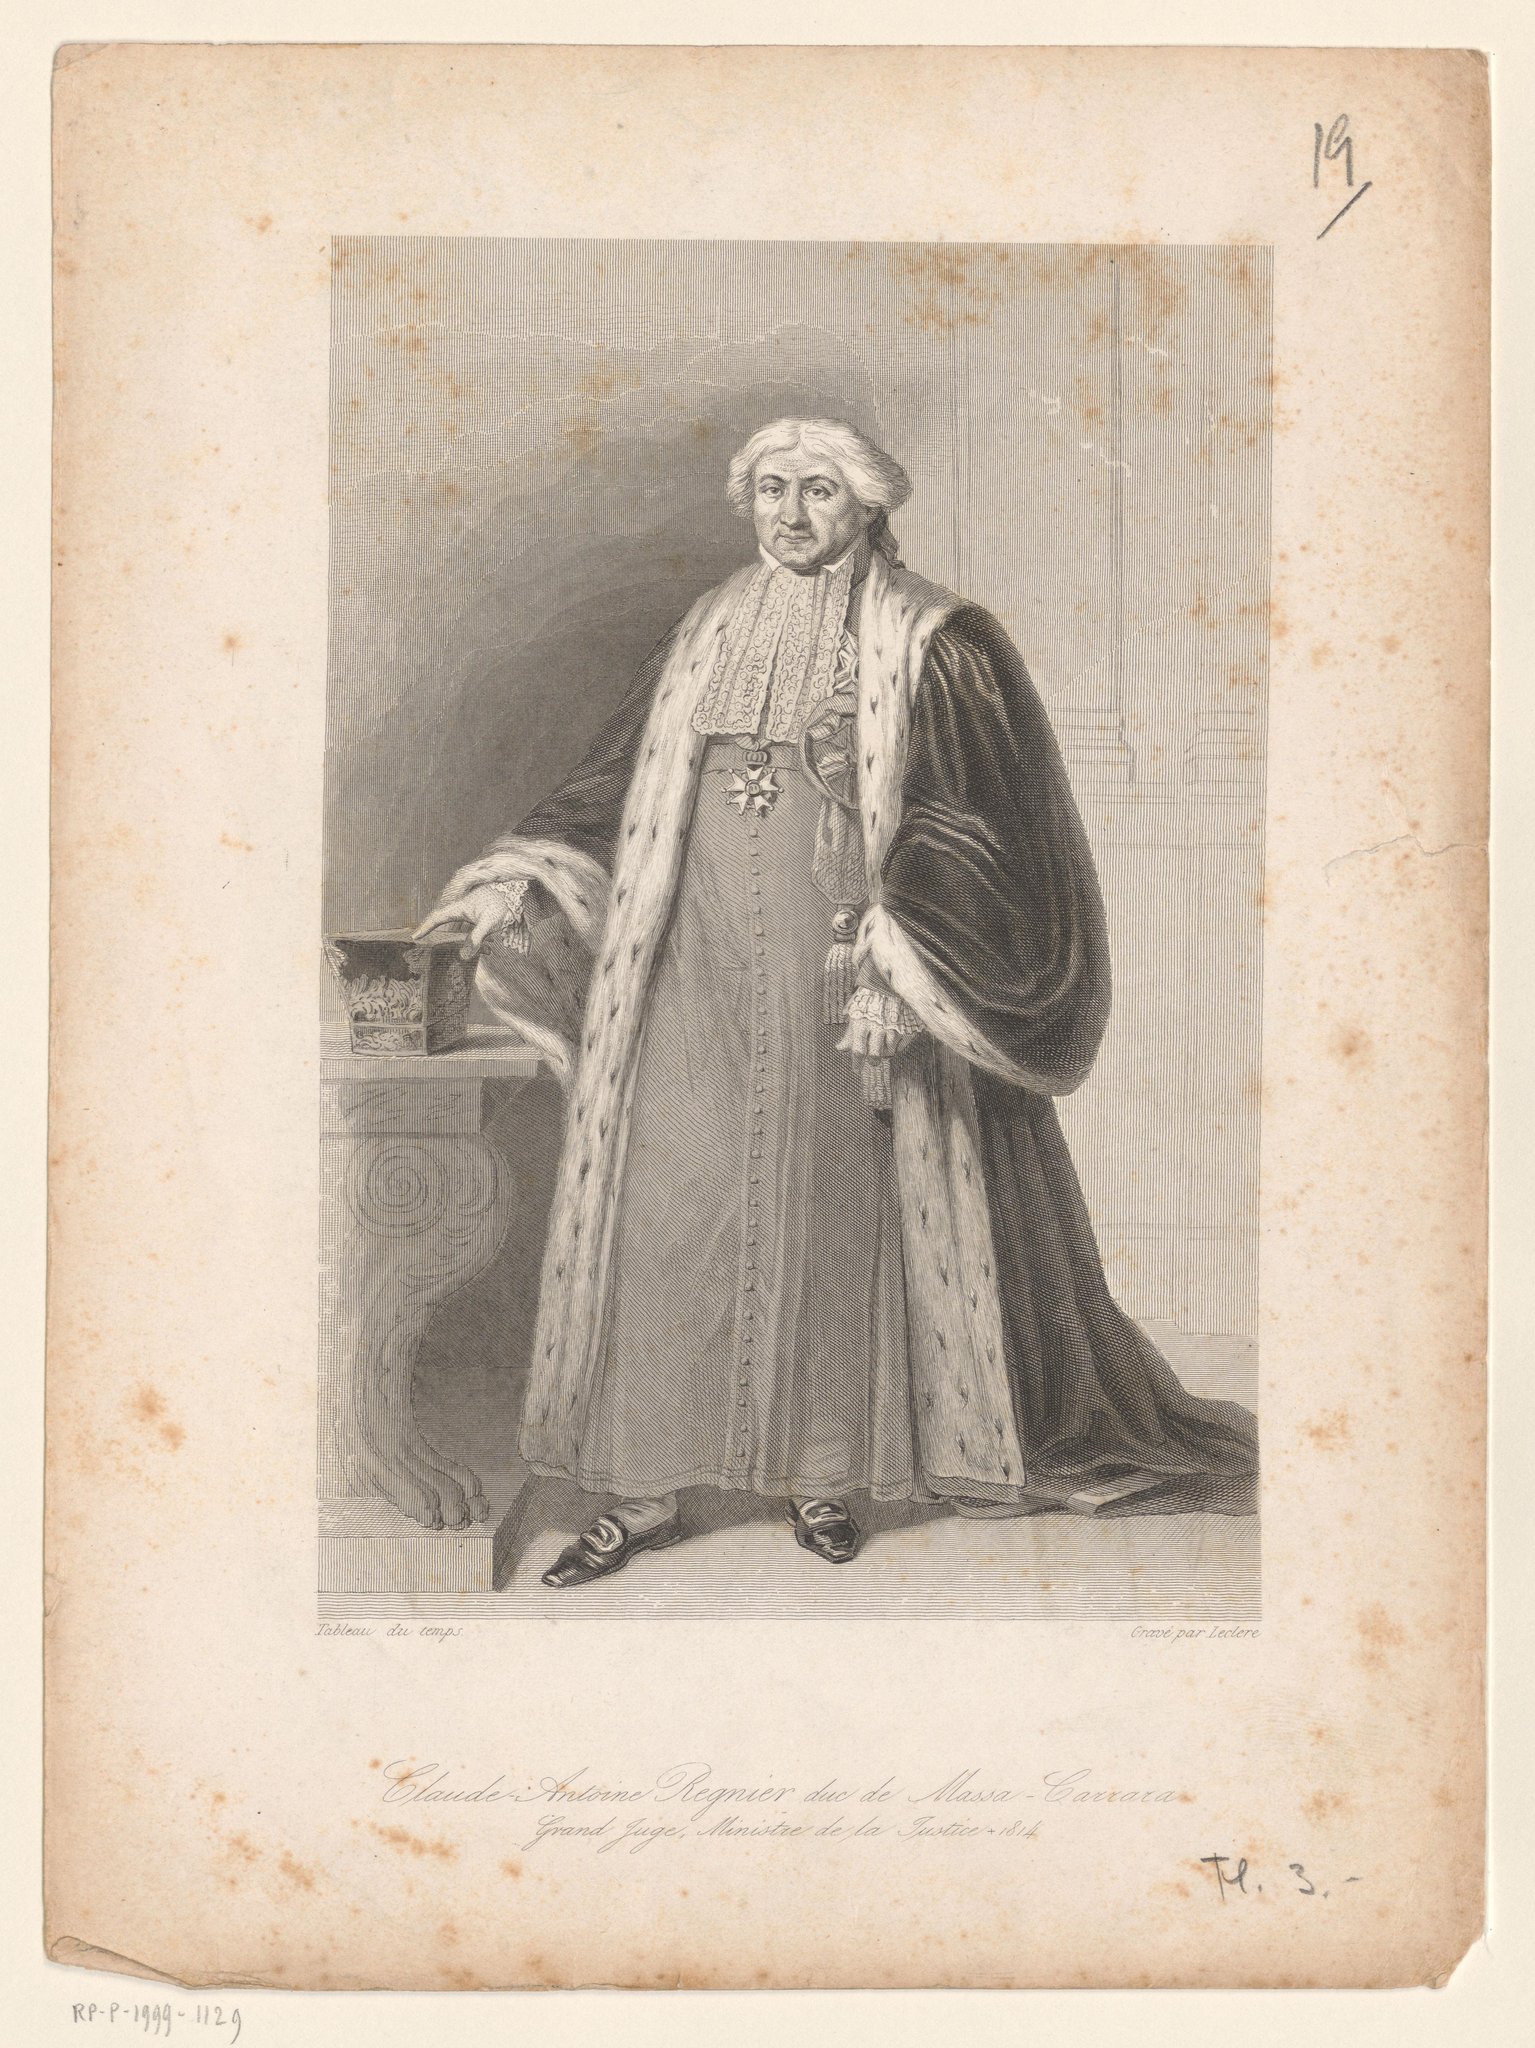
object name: print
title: Portret van Claud-Antoine Regnier, hertog van Massa-Carrara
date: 1838-1841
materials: paper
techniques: engraving, etching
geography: paris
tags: paris, historical persons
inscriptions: collector's mark: Lugt 2228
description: Prent uit: Galeries historiques de Versailles. Parijs: Charles Gavard, 1838-1841.